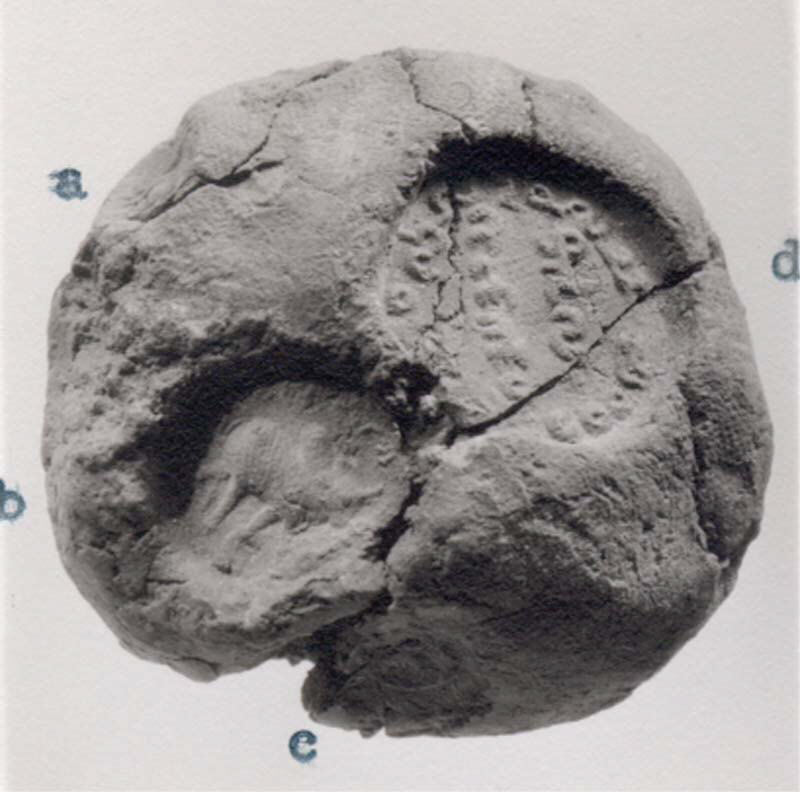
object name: sealing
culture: sasanian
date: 601-700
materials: clay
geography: iran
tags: animals